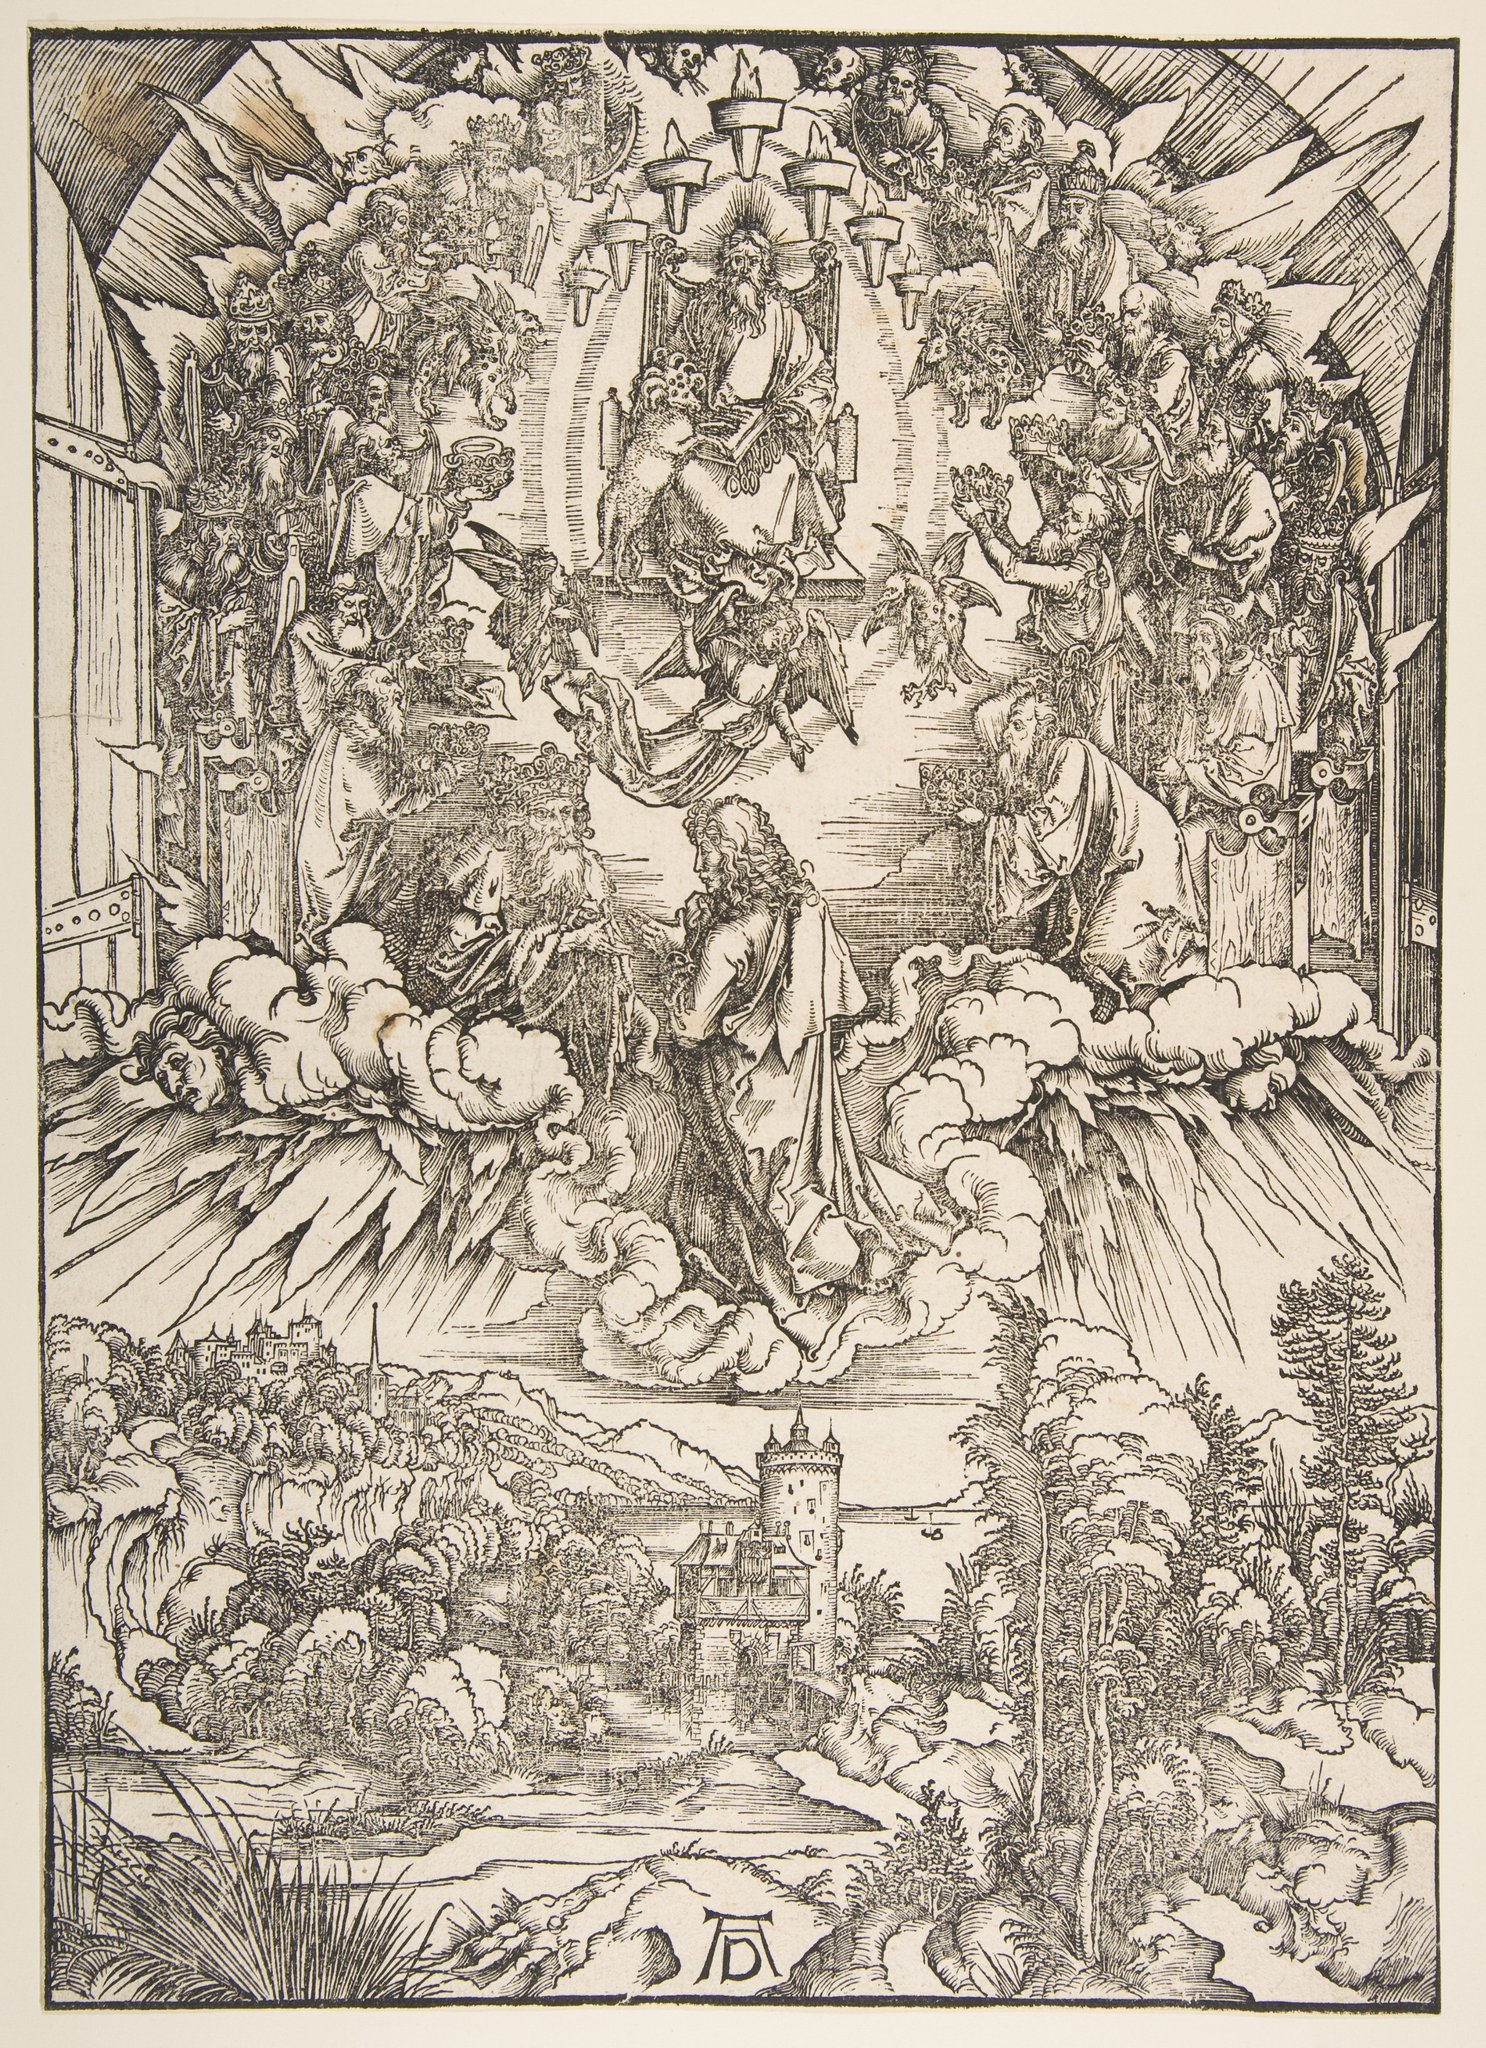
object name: print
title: Saint John before God and the Elders, from "The Apocalypse"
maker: albrecht dürer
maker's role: artist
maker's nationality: german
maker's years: 1471-1528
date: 1496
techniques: woodcut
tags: men,angels,saints